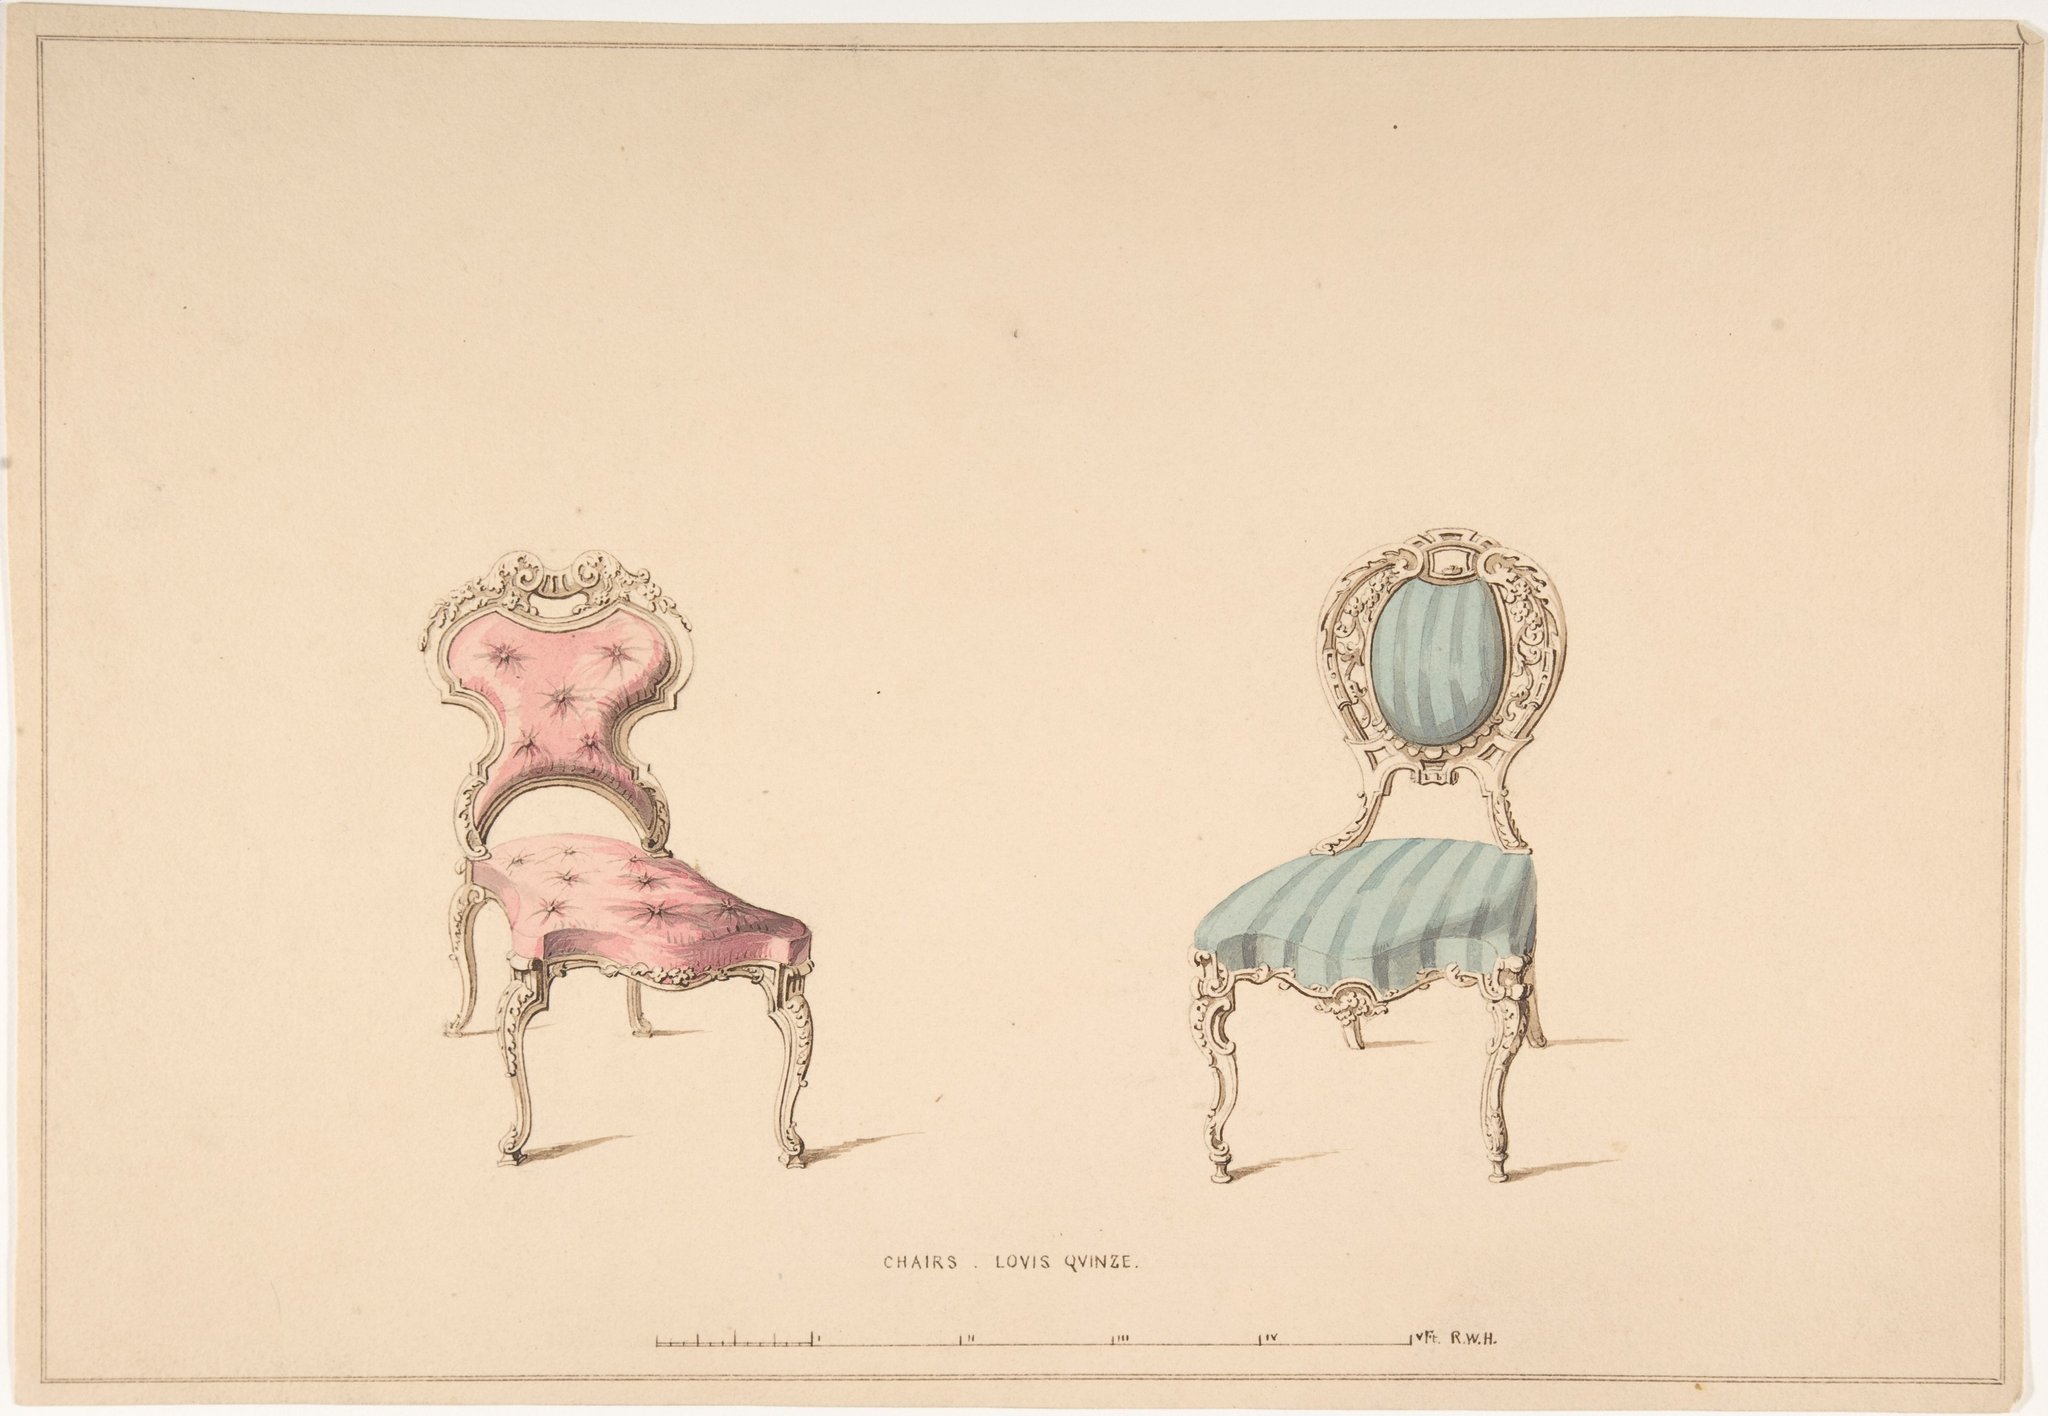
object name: drawing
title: Design for Chairs, Louis Quinze Style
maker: robert william hume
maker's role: artist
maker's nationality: british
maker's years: 1816-1904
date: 1835-1900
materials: graphite, ink, watercolor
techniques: pen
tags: chairs